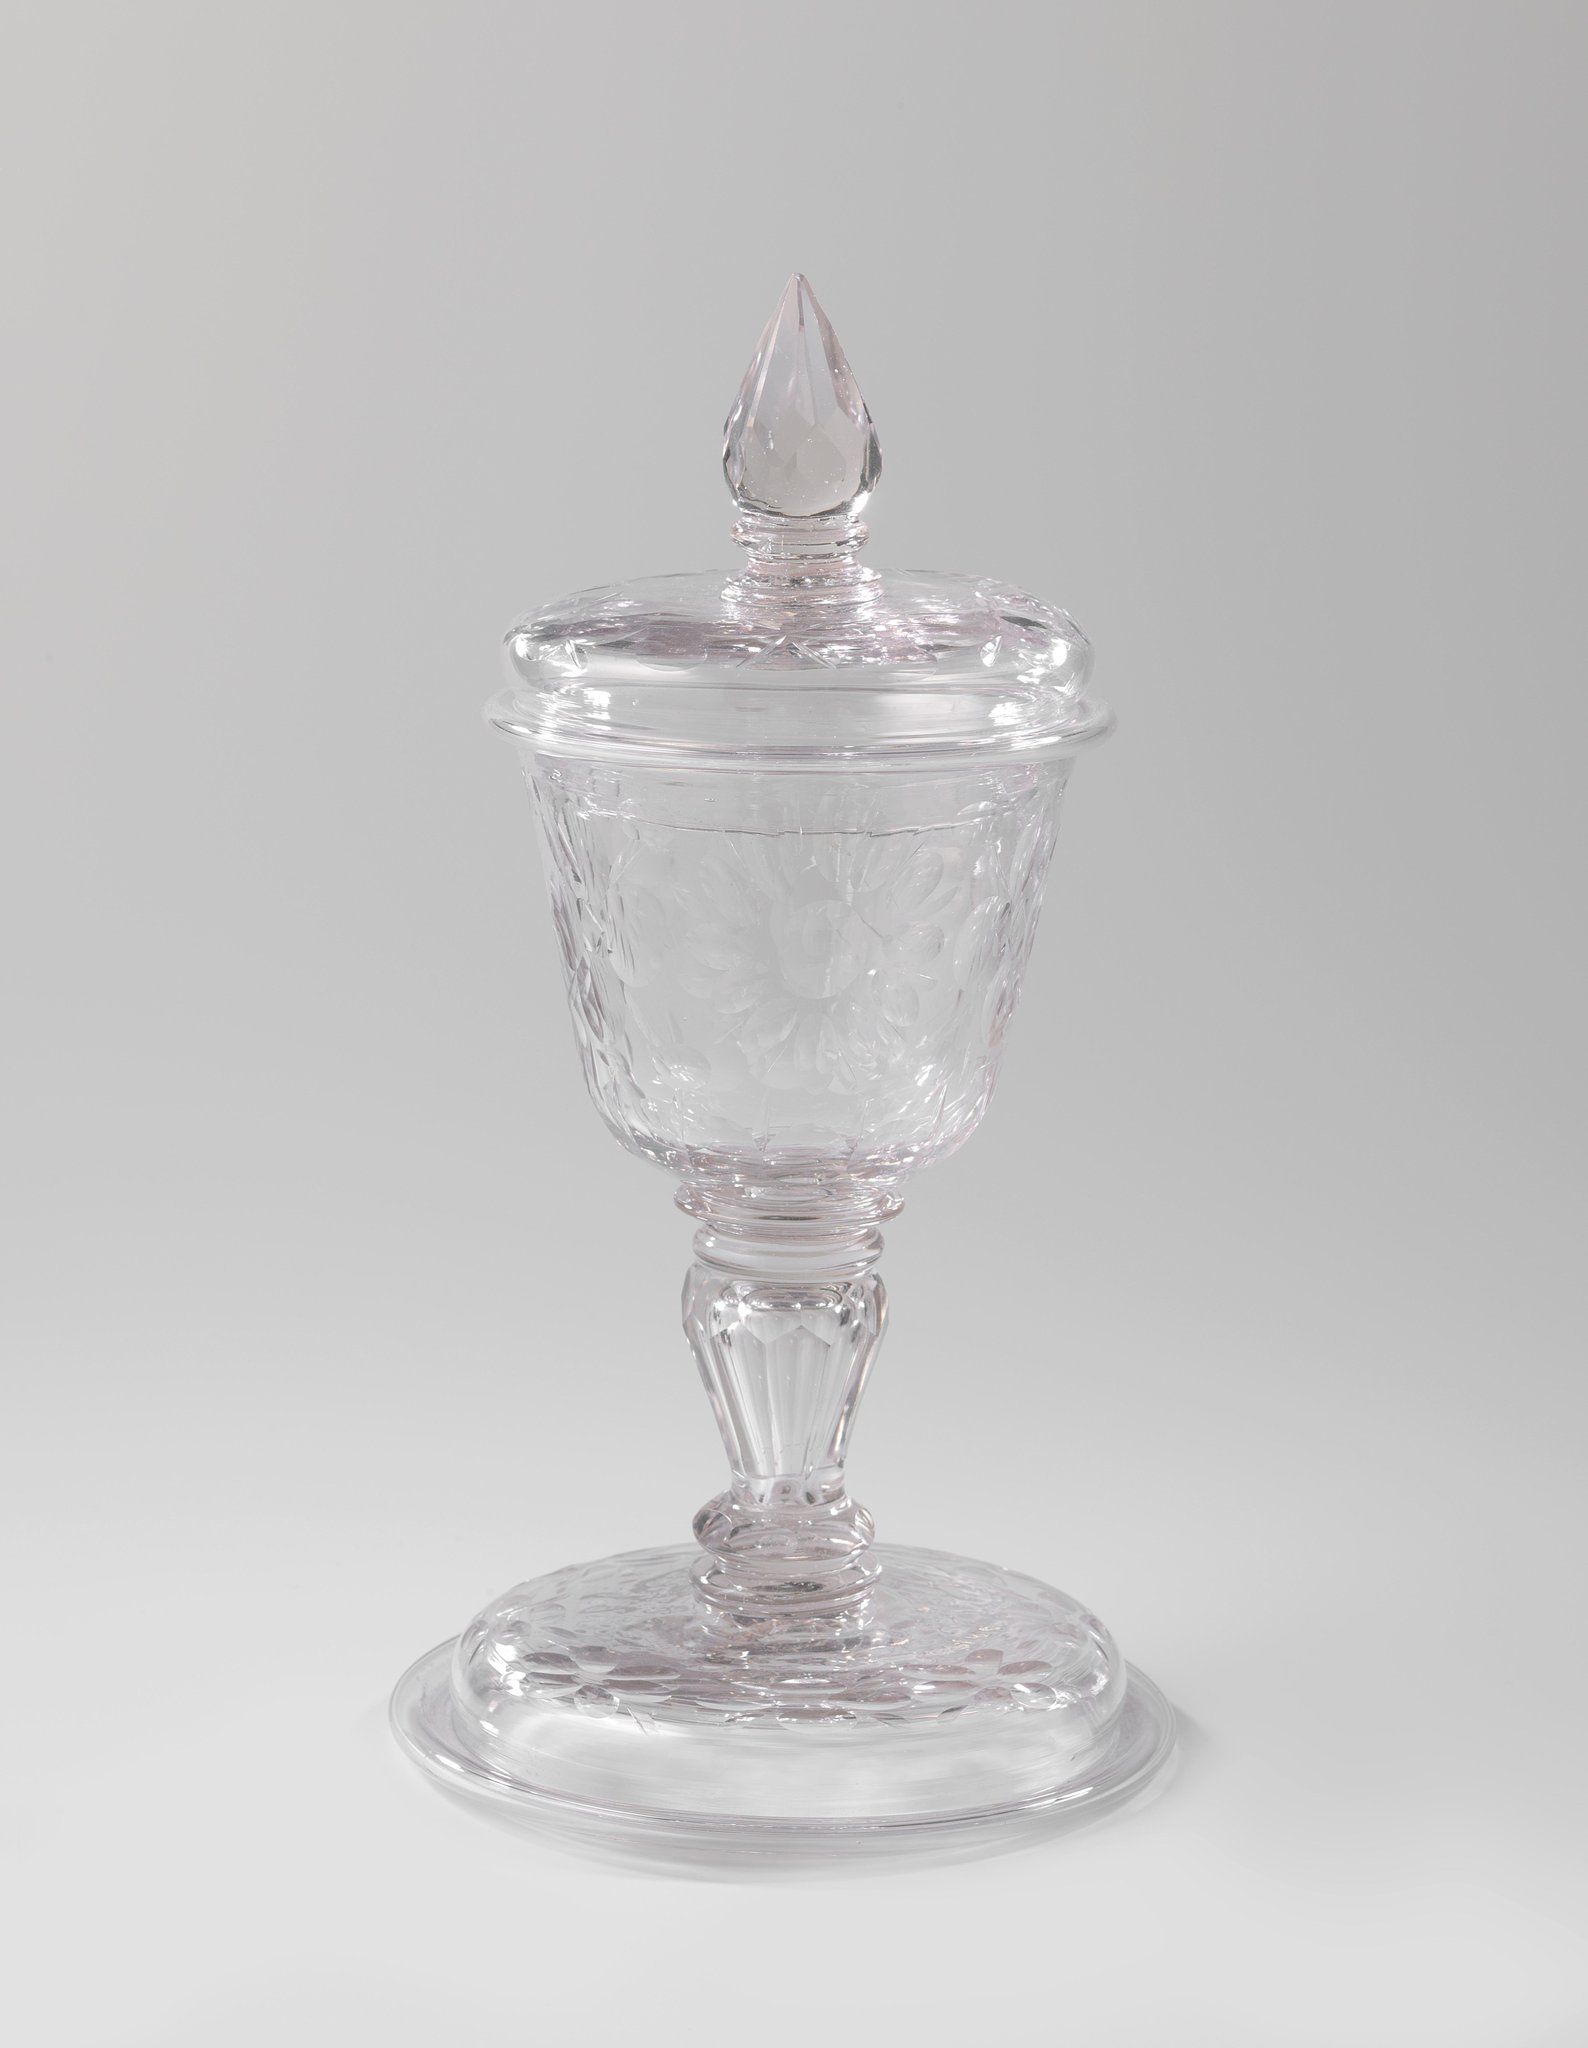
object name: dubbelbokaal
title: Deksel van bokaal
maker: Anonymous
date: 1800-1900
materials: glass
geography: bohemia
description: Bokaal met deksel, staande op een voet welke gediend heeft als deksel van een grotere bokaal (bovenstuk van een dubbelbokaal)